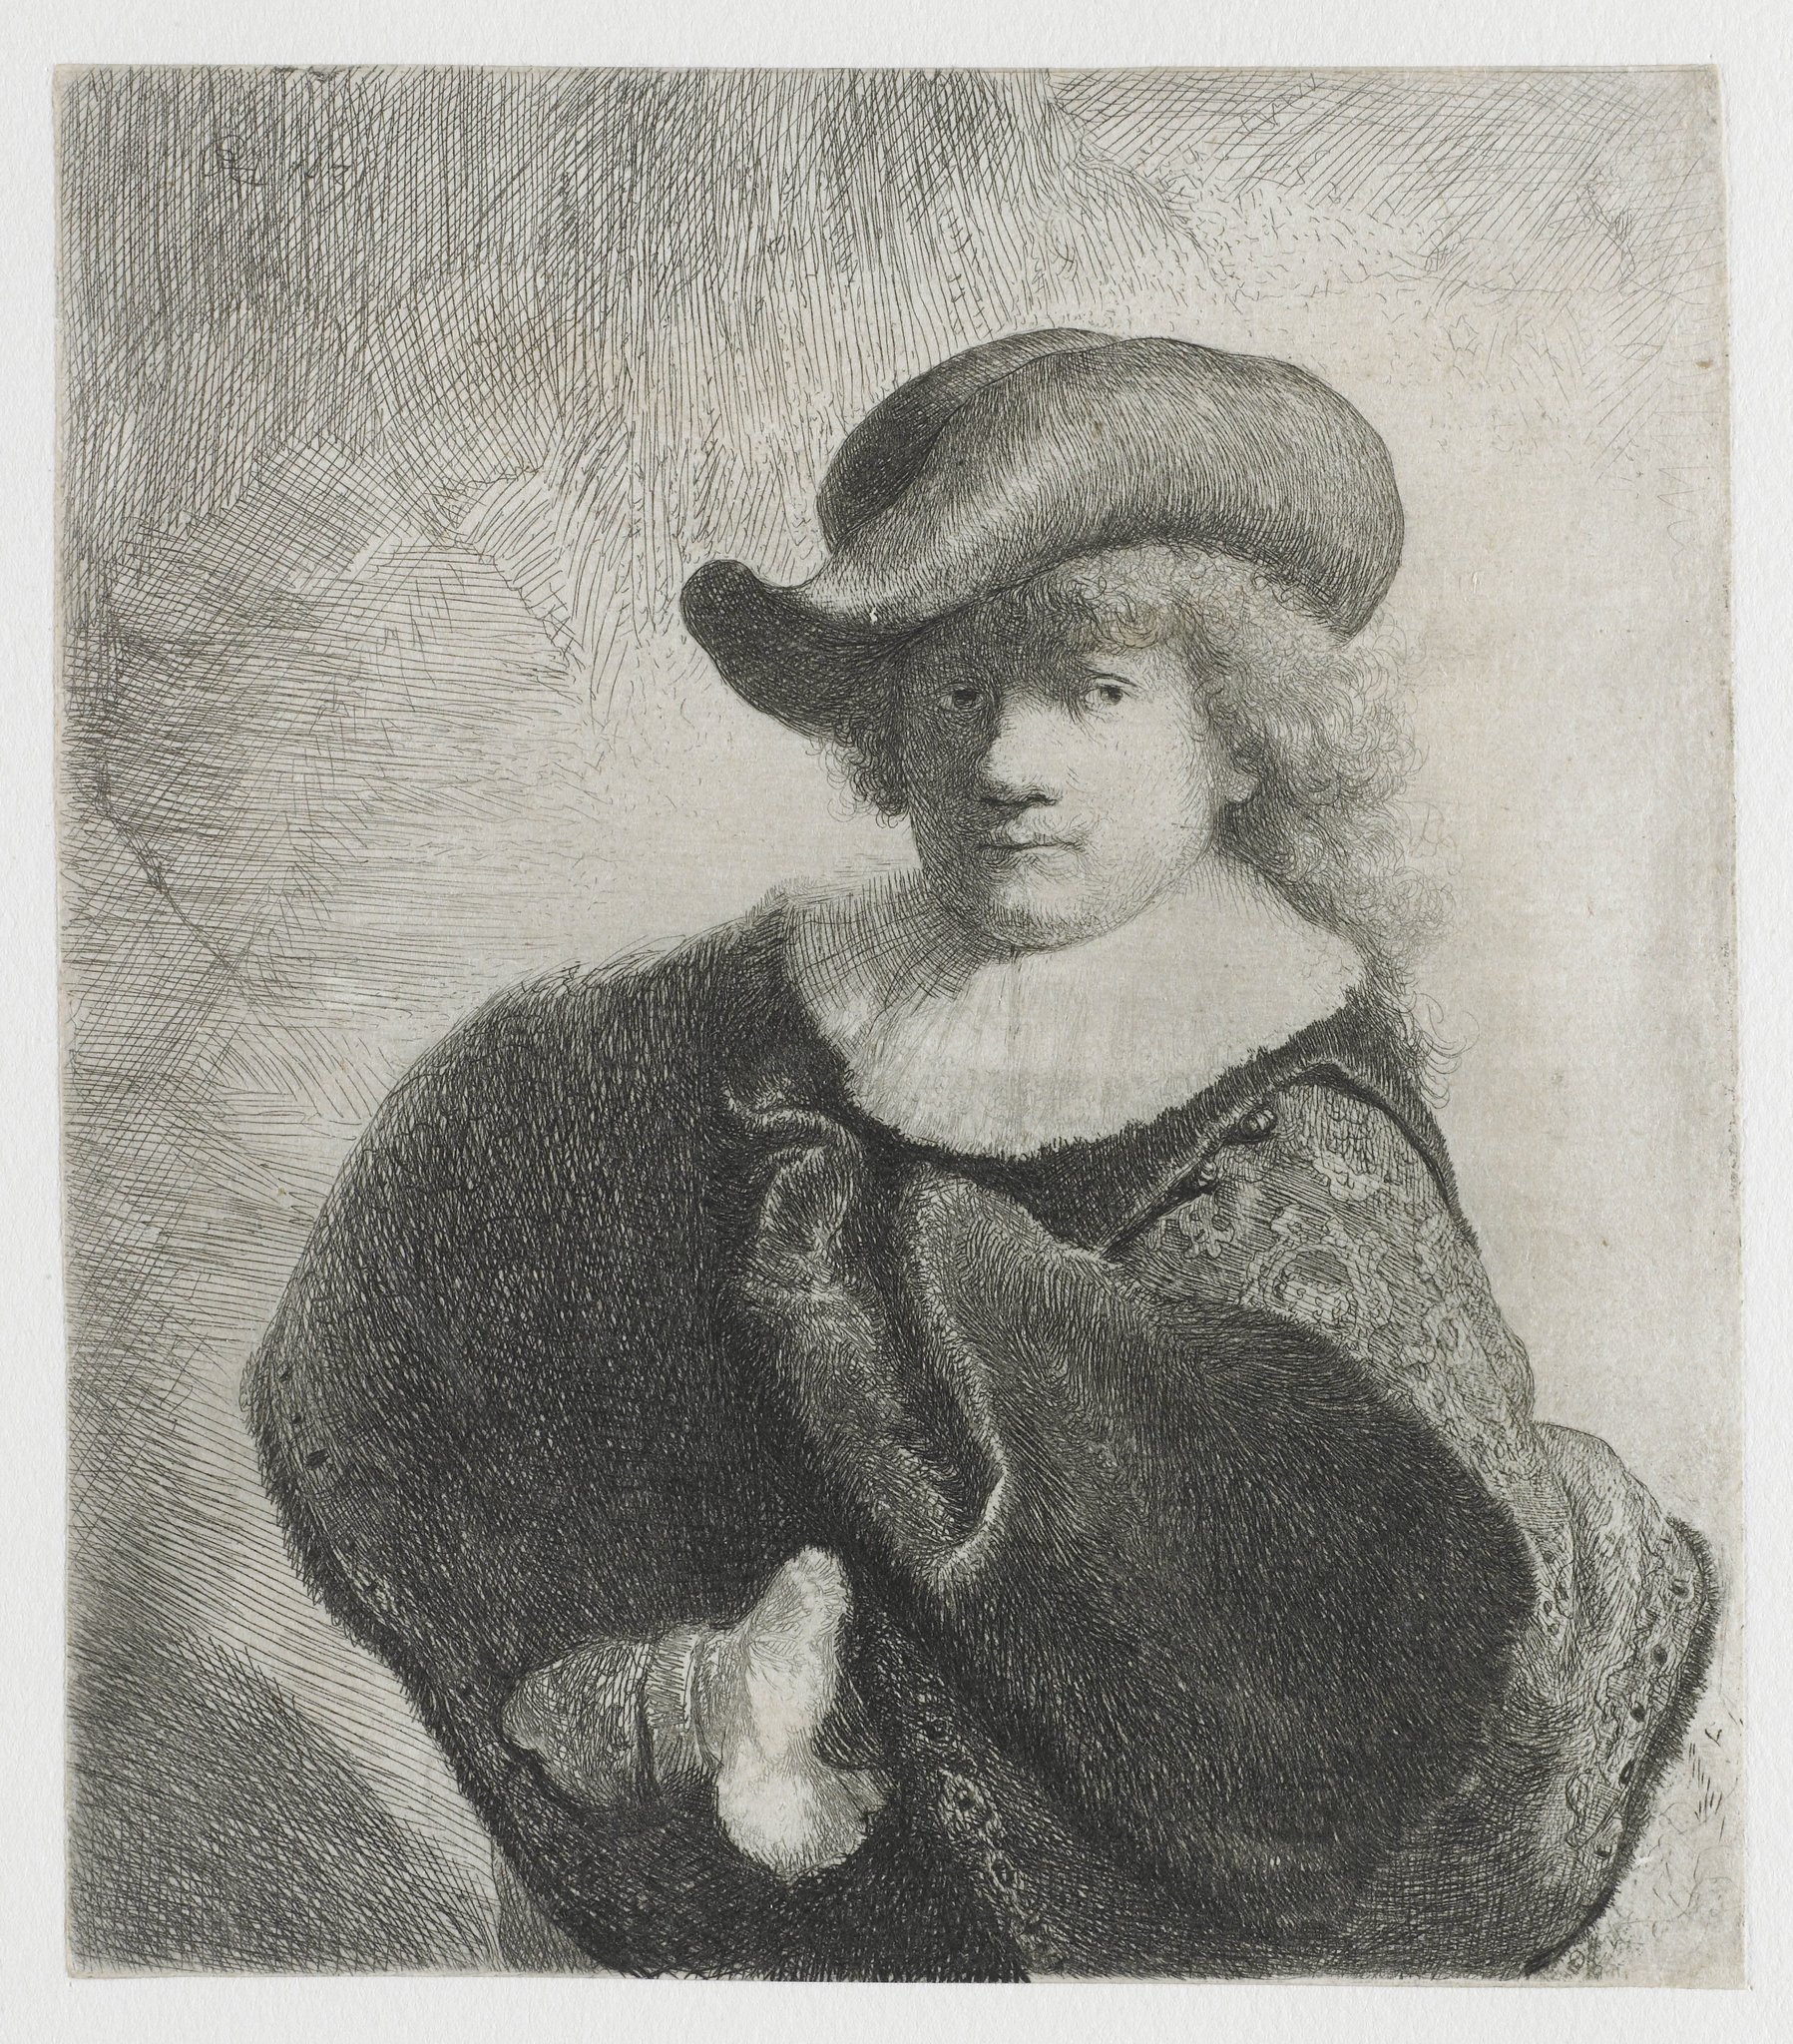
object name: print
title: Self-portrait in a soft hat and a patterned cloak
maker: rembrandt van rijn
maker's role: draughtsman, painter, print maker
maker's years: 1606-1669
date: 1631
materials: paper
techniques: drypoint, etching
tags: leiden, amsterdam, painter, print maker, draughtsman, rembrandt van rijn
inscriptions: collector's mark: Lugt 2228, monogram and date: ‘RHL 1631’